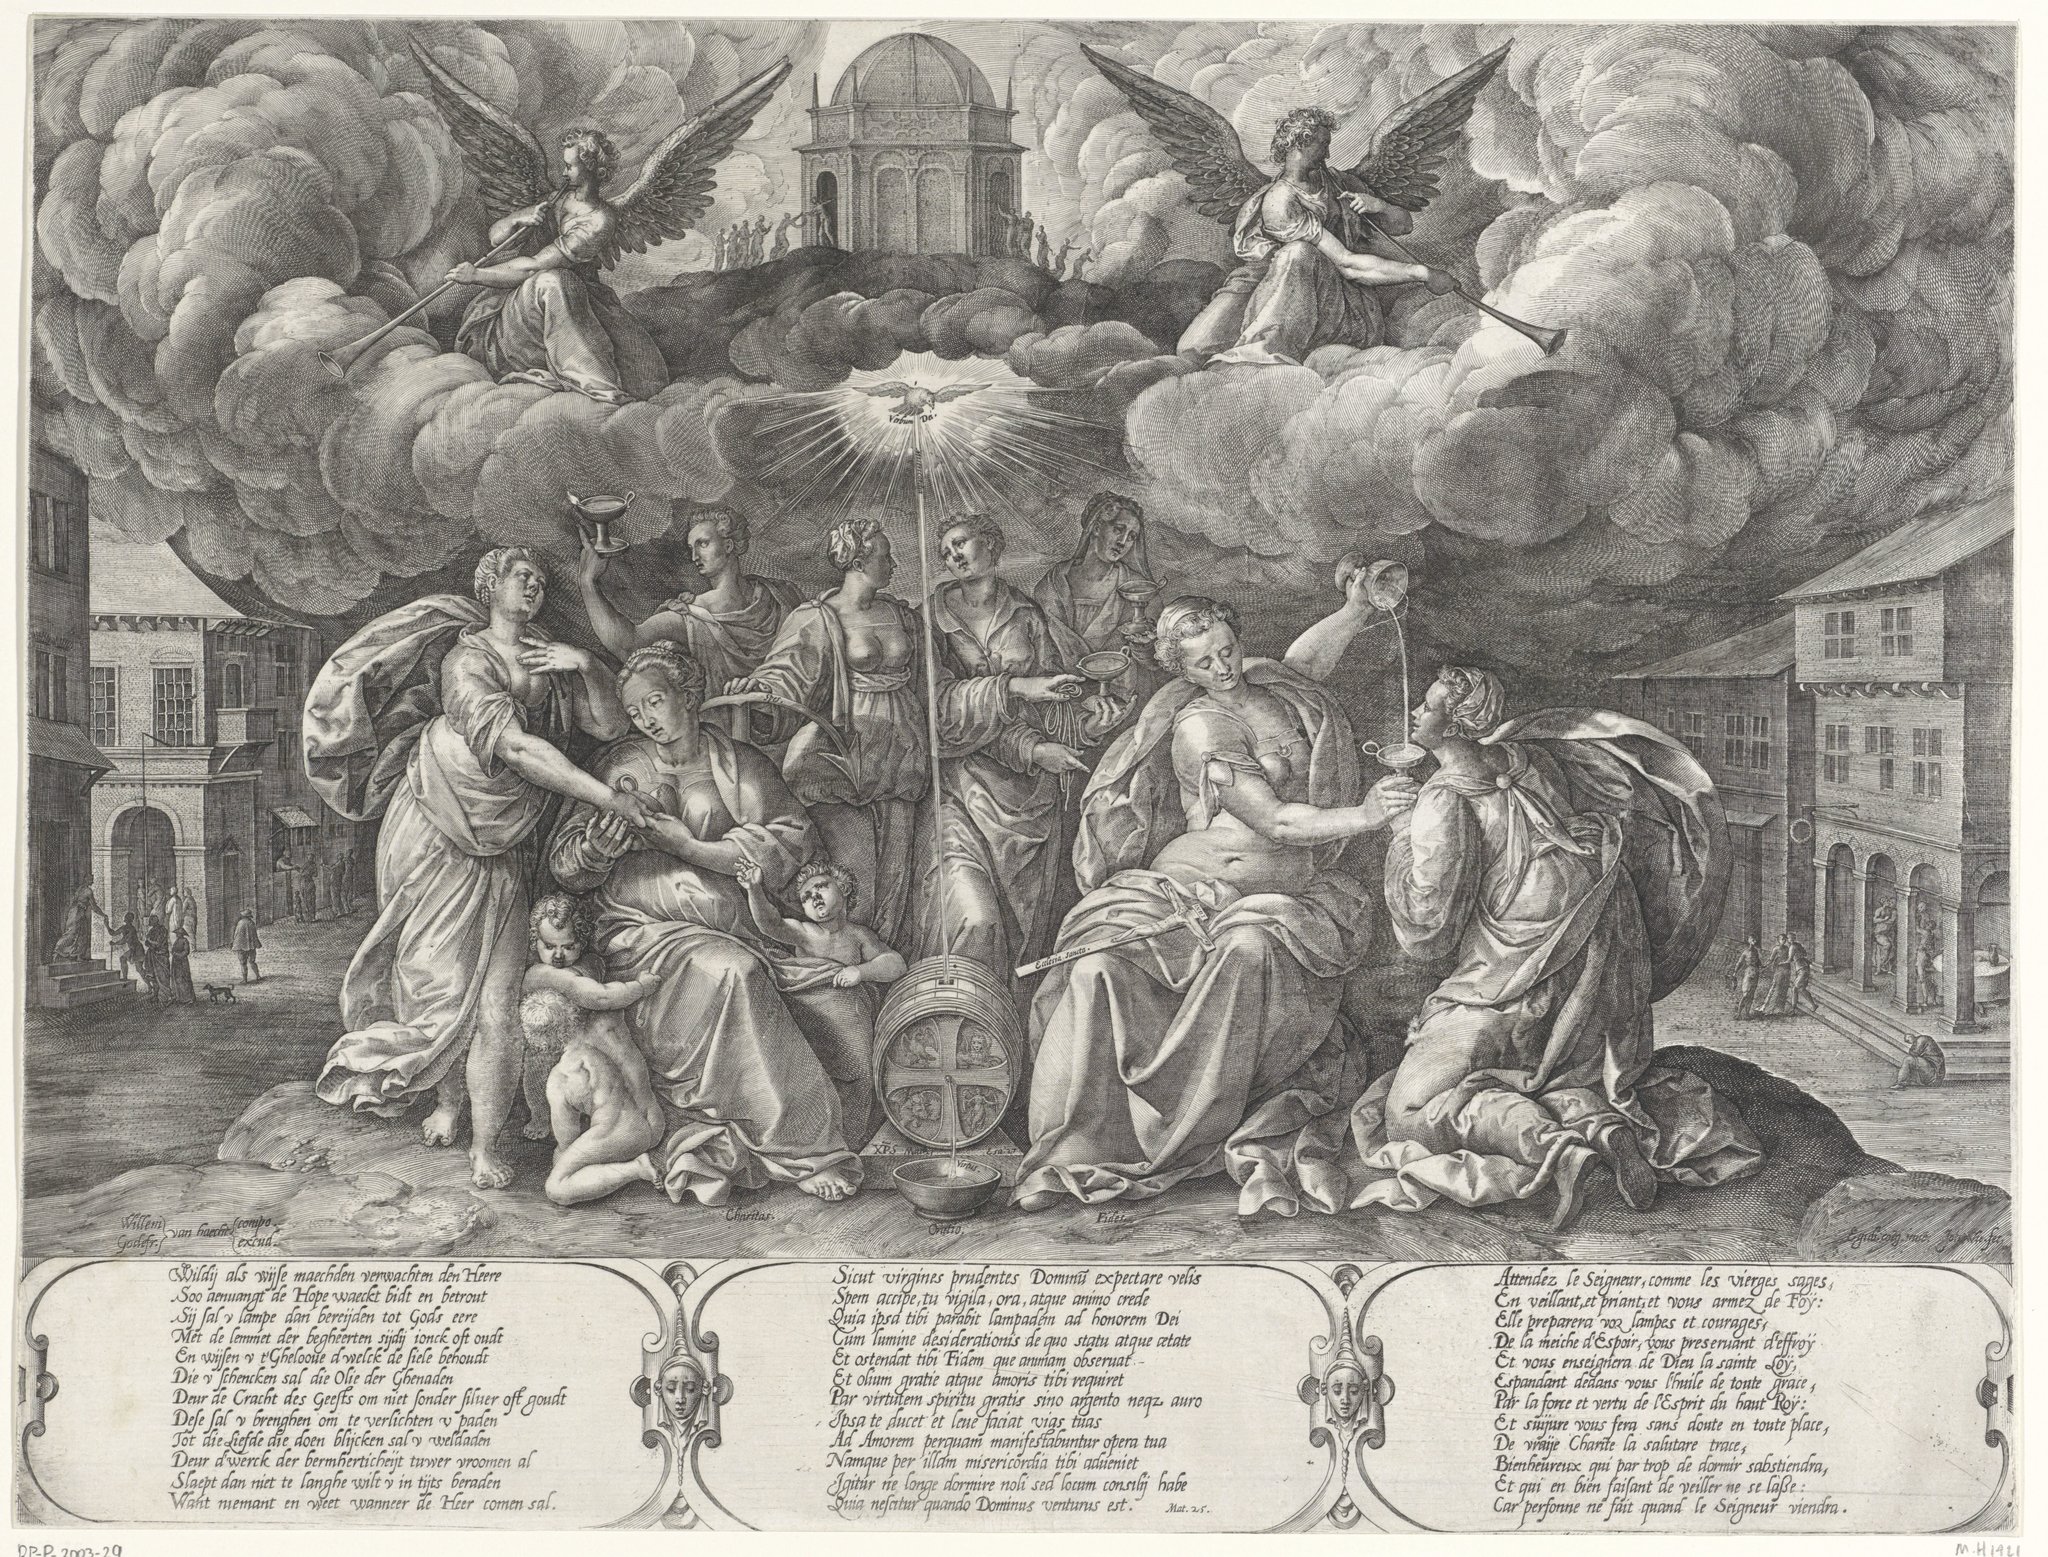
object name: print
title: Gelijkenis van de vijf wijze en de vijf dwaze maagden, vergezeld door de drie goddelijke deugden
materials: paper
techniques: engraving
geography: antwerp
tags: the three theological virtues, representation of wise virgin(s), the (seven) acts of mercy, holy ghost represented as a dove (in flames)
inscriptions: signature: ‘Joh. Wie. fec.’ Lugt, caption: ‘Wildij als wijse maechden...de heer comen sal’, address: ‘Willem Godefr. van haecht compo / excud.’, signature: ‘Egidius Cog. inve.’ Lugt, collector's mark: 2228, caption: ‘Attendez le Seigneur...le Seigneur viendra.’, collector's mark: 2760, caption: ‘Sicut virgines prudentes...Dominus venturus est. Mat. 25’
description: De vijf wijze maagden worden vergezeld door de drie goddelijke deugden. Liefde houdt de hand vast van een van hen. Geloof schenkt haar beker leeg in de beker van een geknielde maagd. In het midden Hoop. Boven hen de Heilige Geest in de gedaante van een duif. De duif vult het vat met vloeistof. In de wolken kondigen twee engelen de komst van de bruidegom aan door te blazen op de bazuin. In de tempel geheel bovenaan ontvangt Christus de vijf wijze maagden. De vijf dwaze maagden zijn aan de rechterzijde van de tempel buiten gesloten. Op de achtergrond is te zien hoe de wijze maagden de werken van barmhartigheid uitvoeren. In de marge een onderschrift, in drie kolommen, in het Nederlands, Latijn en Frans.